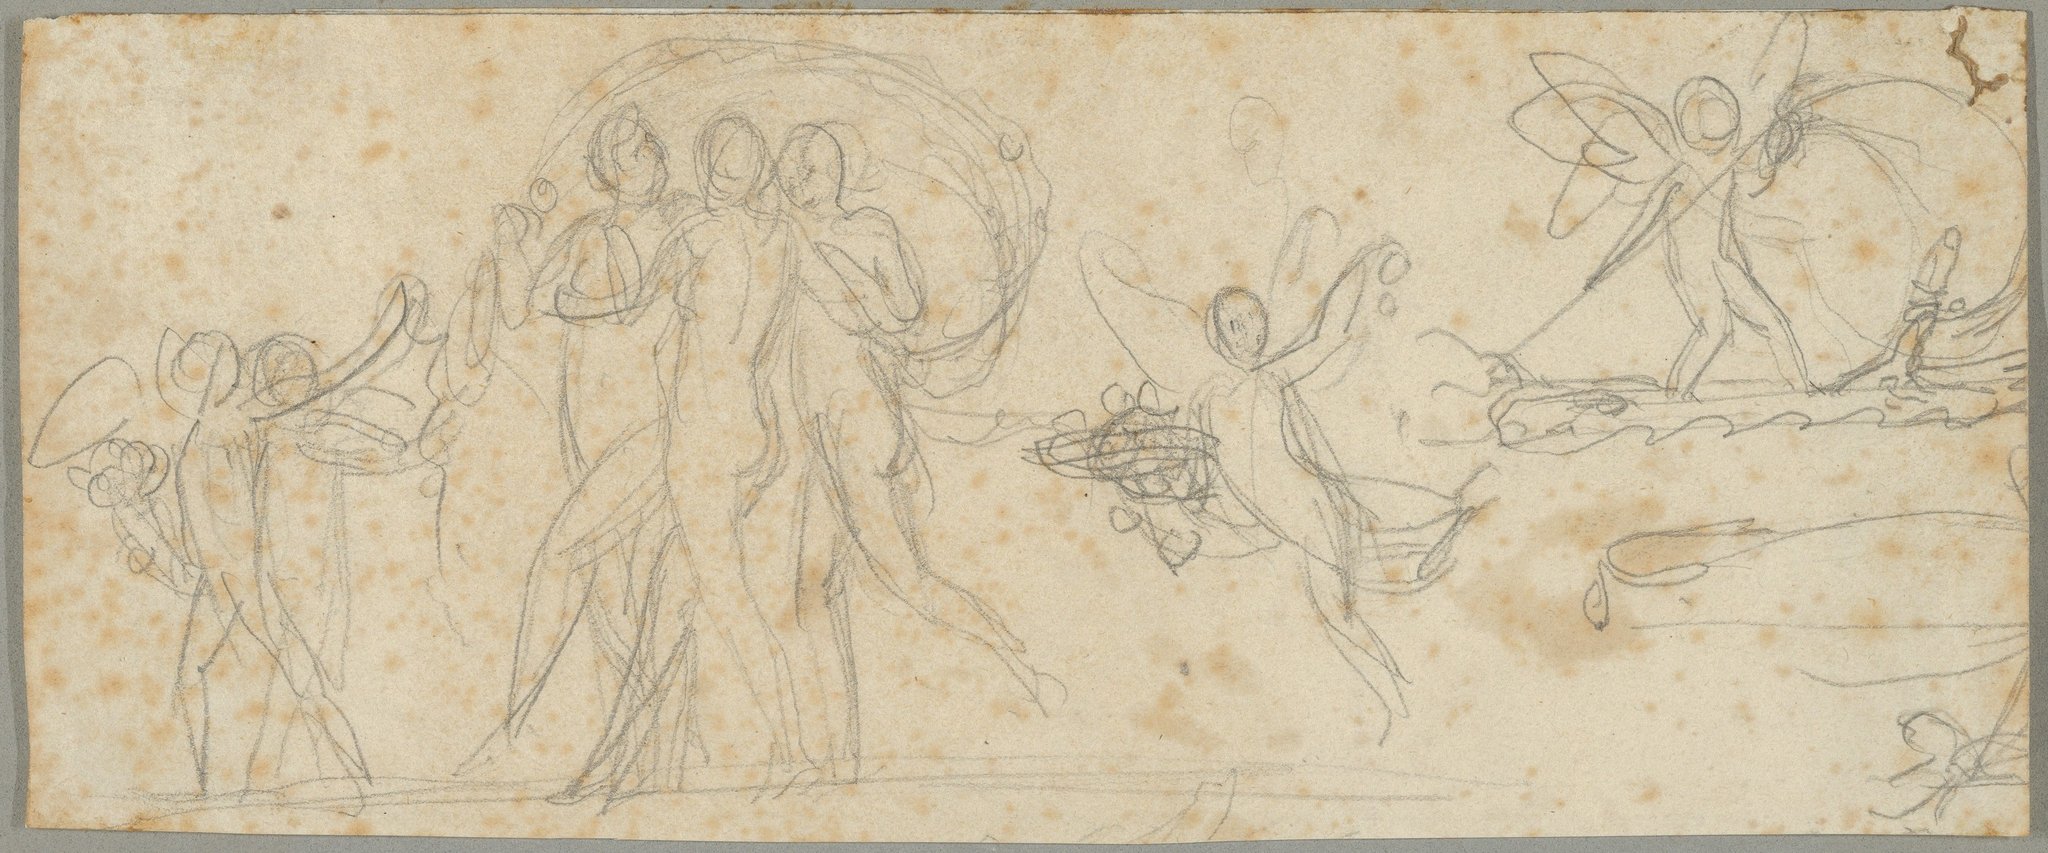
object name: drawing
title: The Three Graces and Putti; verso: Various Studies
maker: bertel thorvaldsen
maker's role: artist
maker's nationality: danish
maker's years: 1770-1844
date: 1801-1833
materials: graphite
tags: women,putti